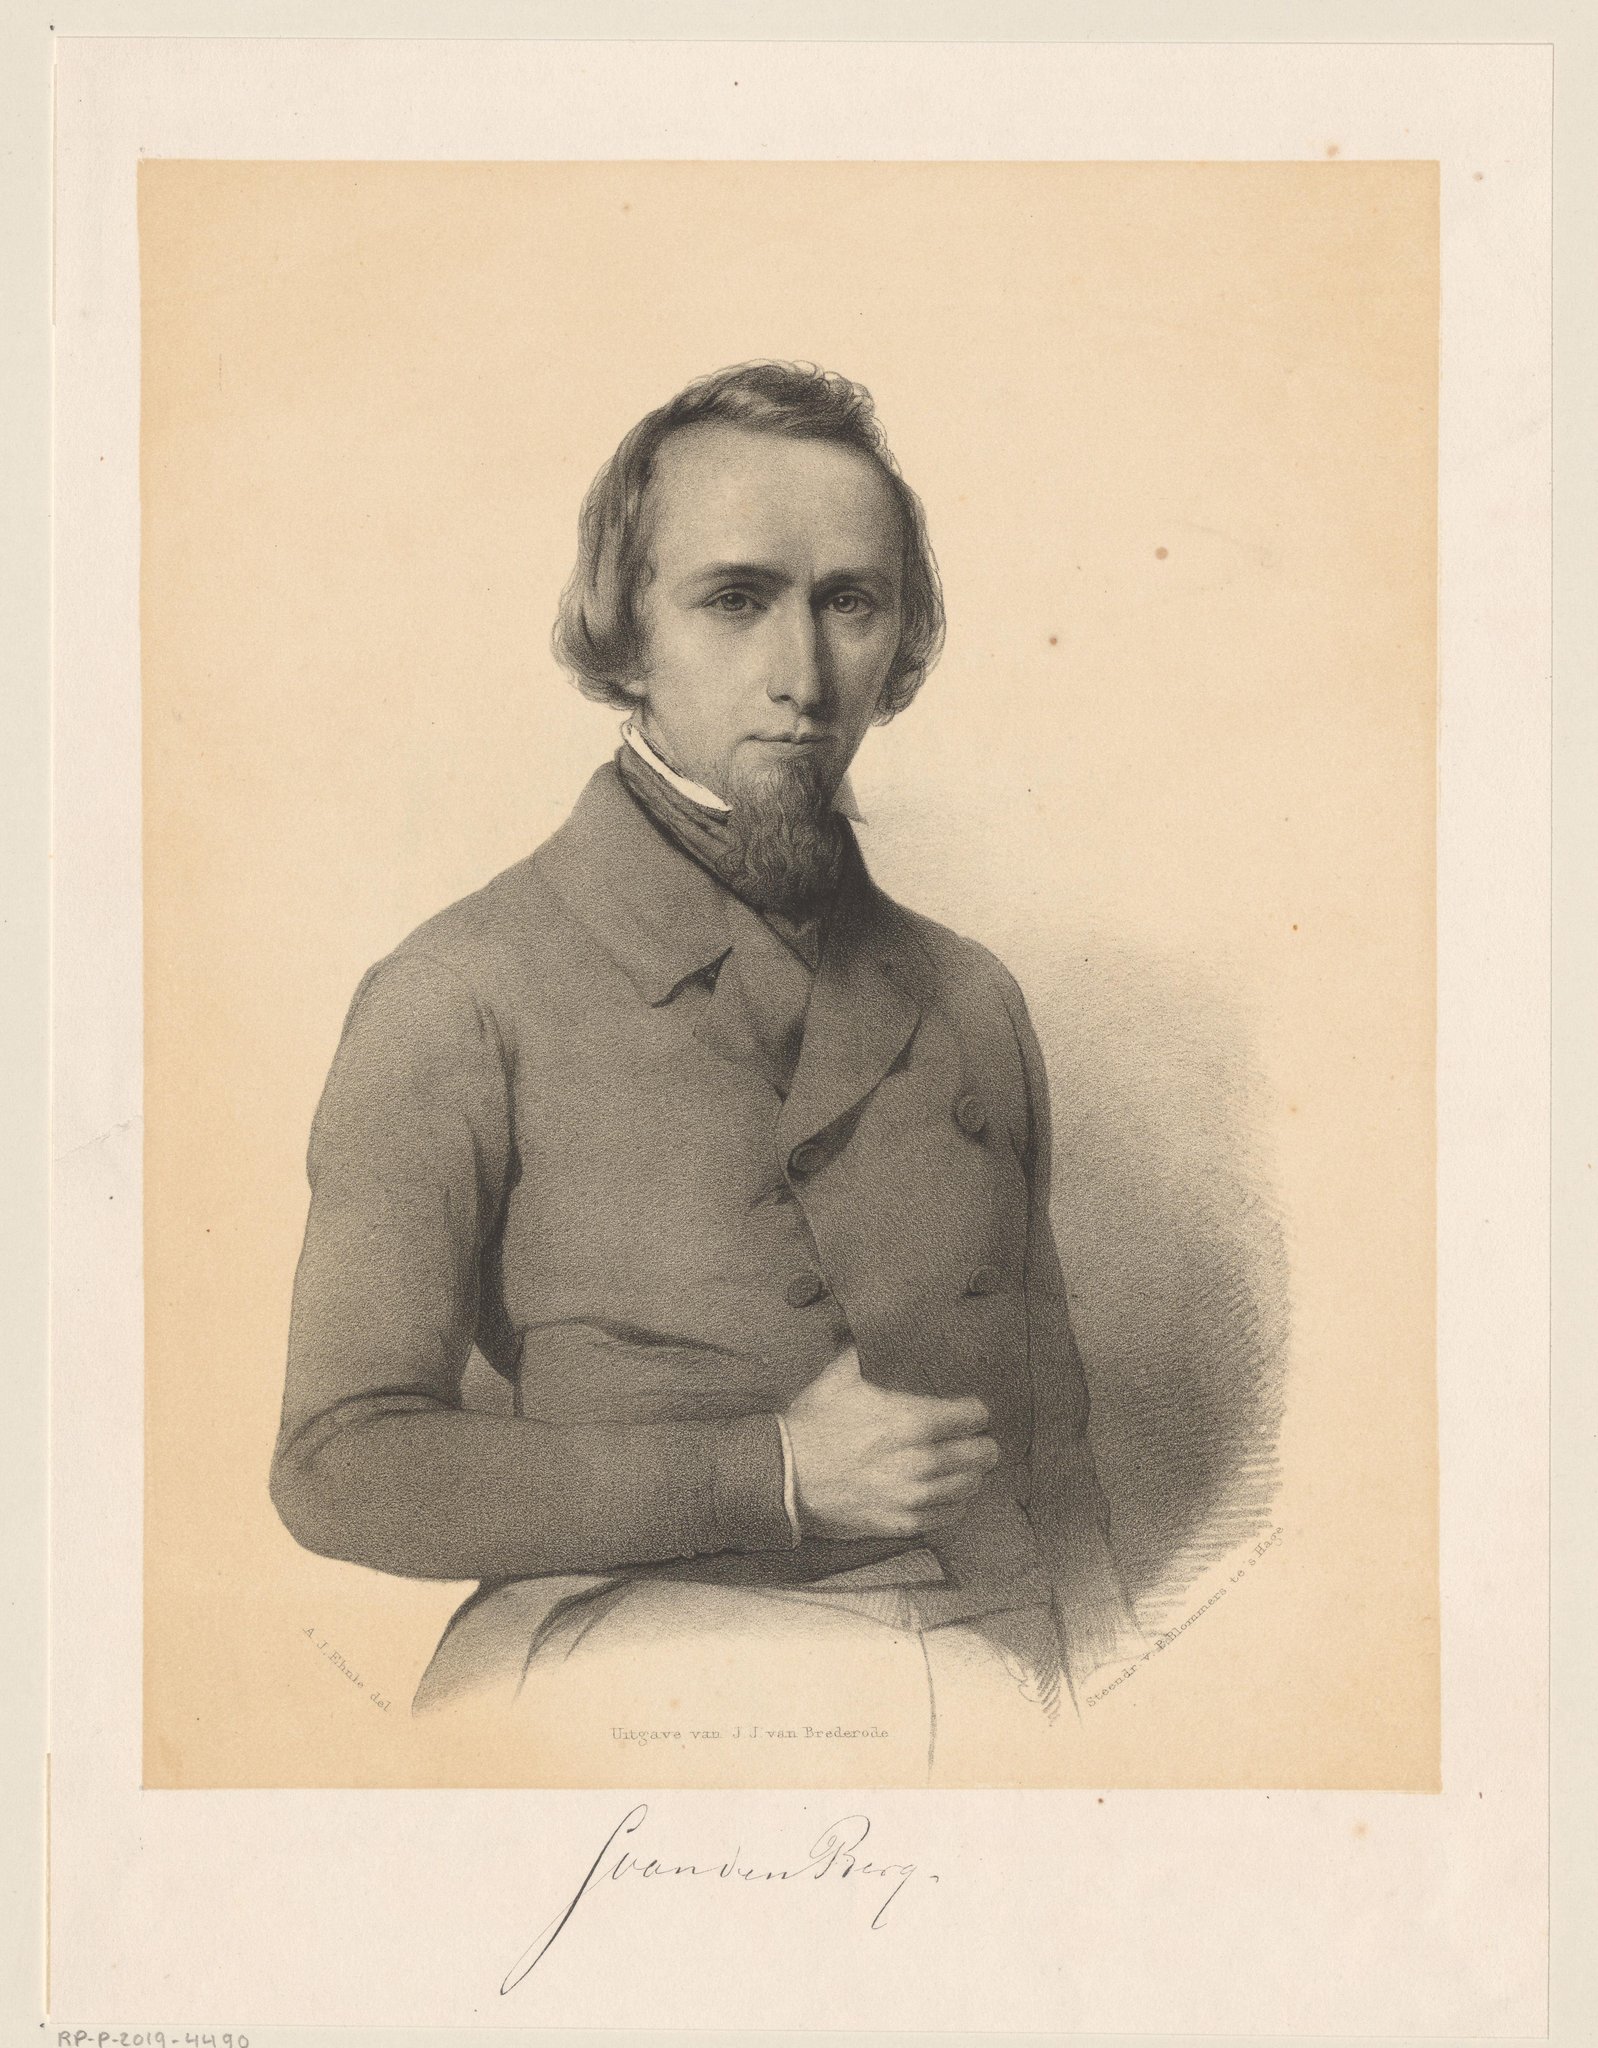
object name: print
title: Portret van Simon van den Berg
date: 1848-1883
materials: paper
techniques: tone lithography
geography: the hague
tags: overschie, arnhem, print maker, simon van den berg, historical persons, portrait, self-portrait of painter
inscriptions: collector's mark: Lugt 2228